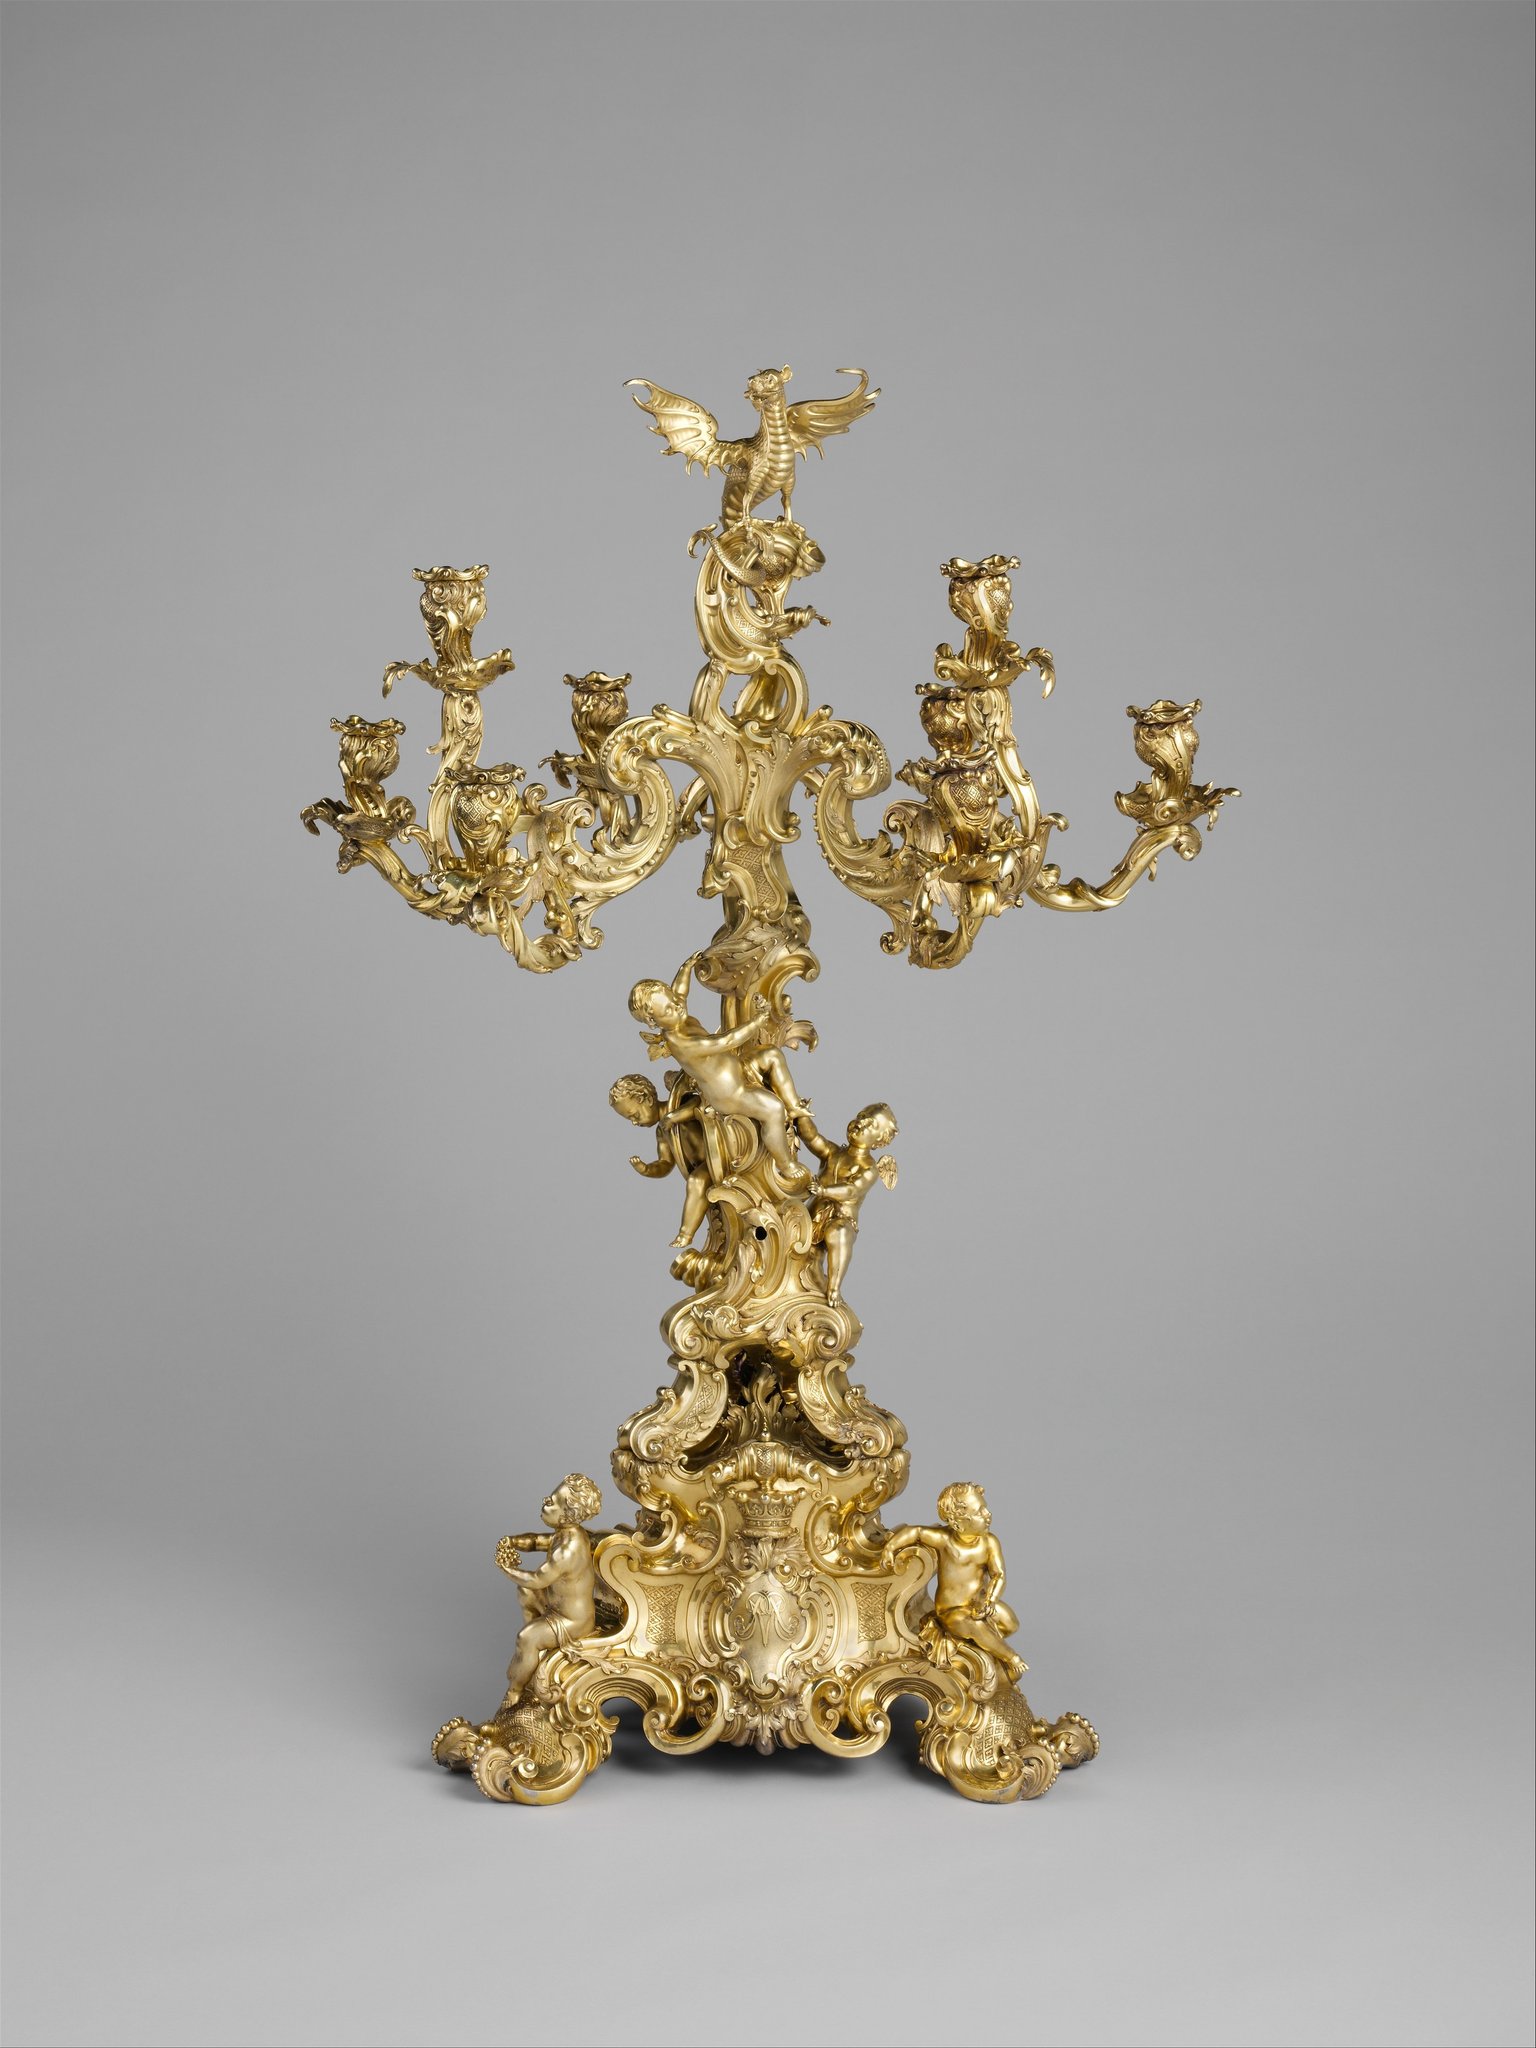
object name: candelabrum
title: Nine-light candelabrum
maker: paul storr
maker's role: maker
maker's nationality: british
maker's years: 1771-1844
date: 1835-1836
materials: gilt, silver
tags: children,cupid,dragons